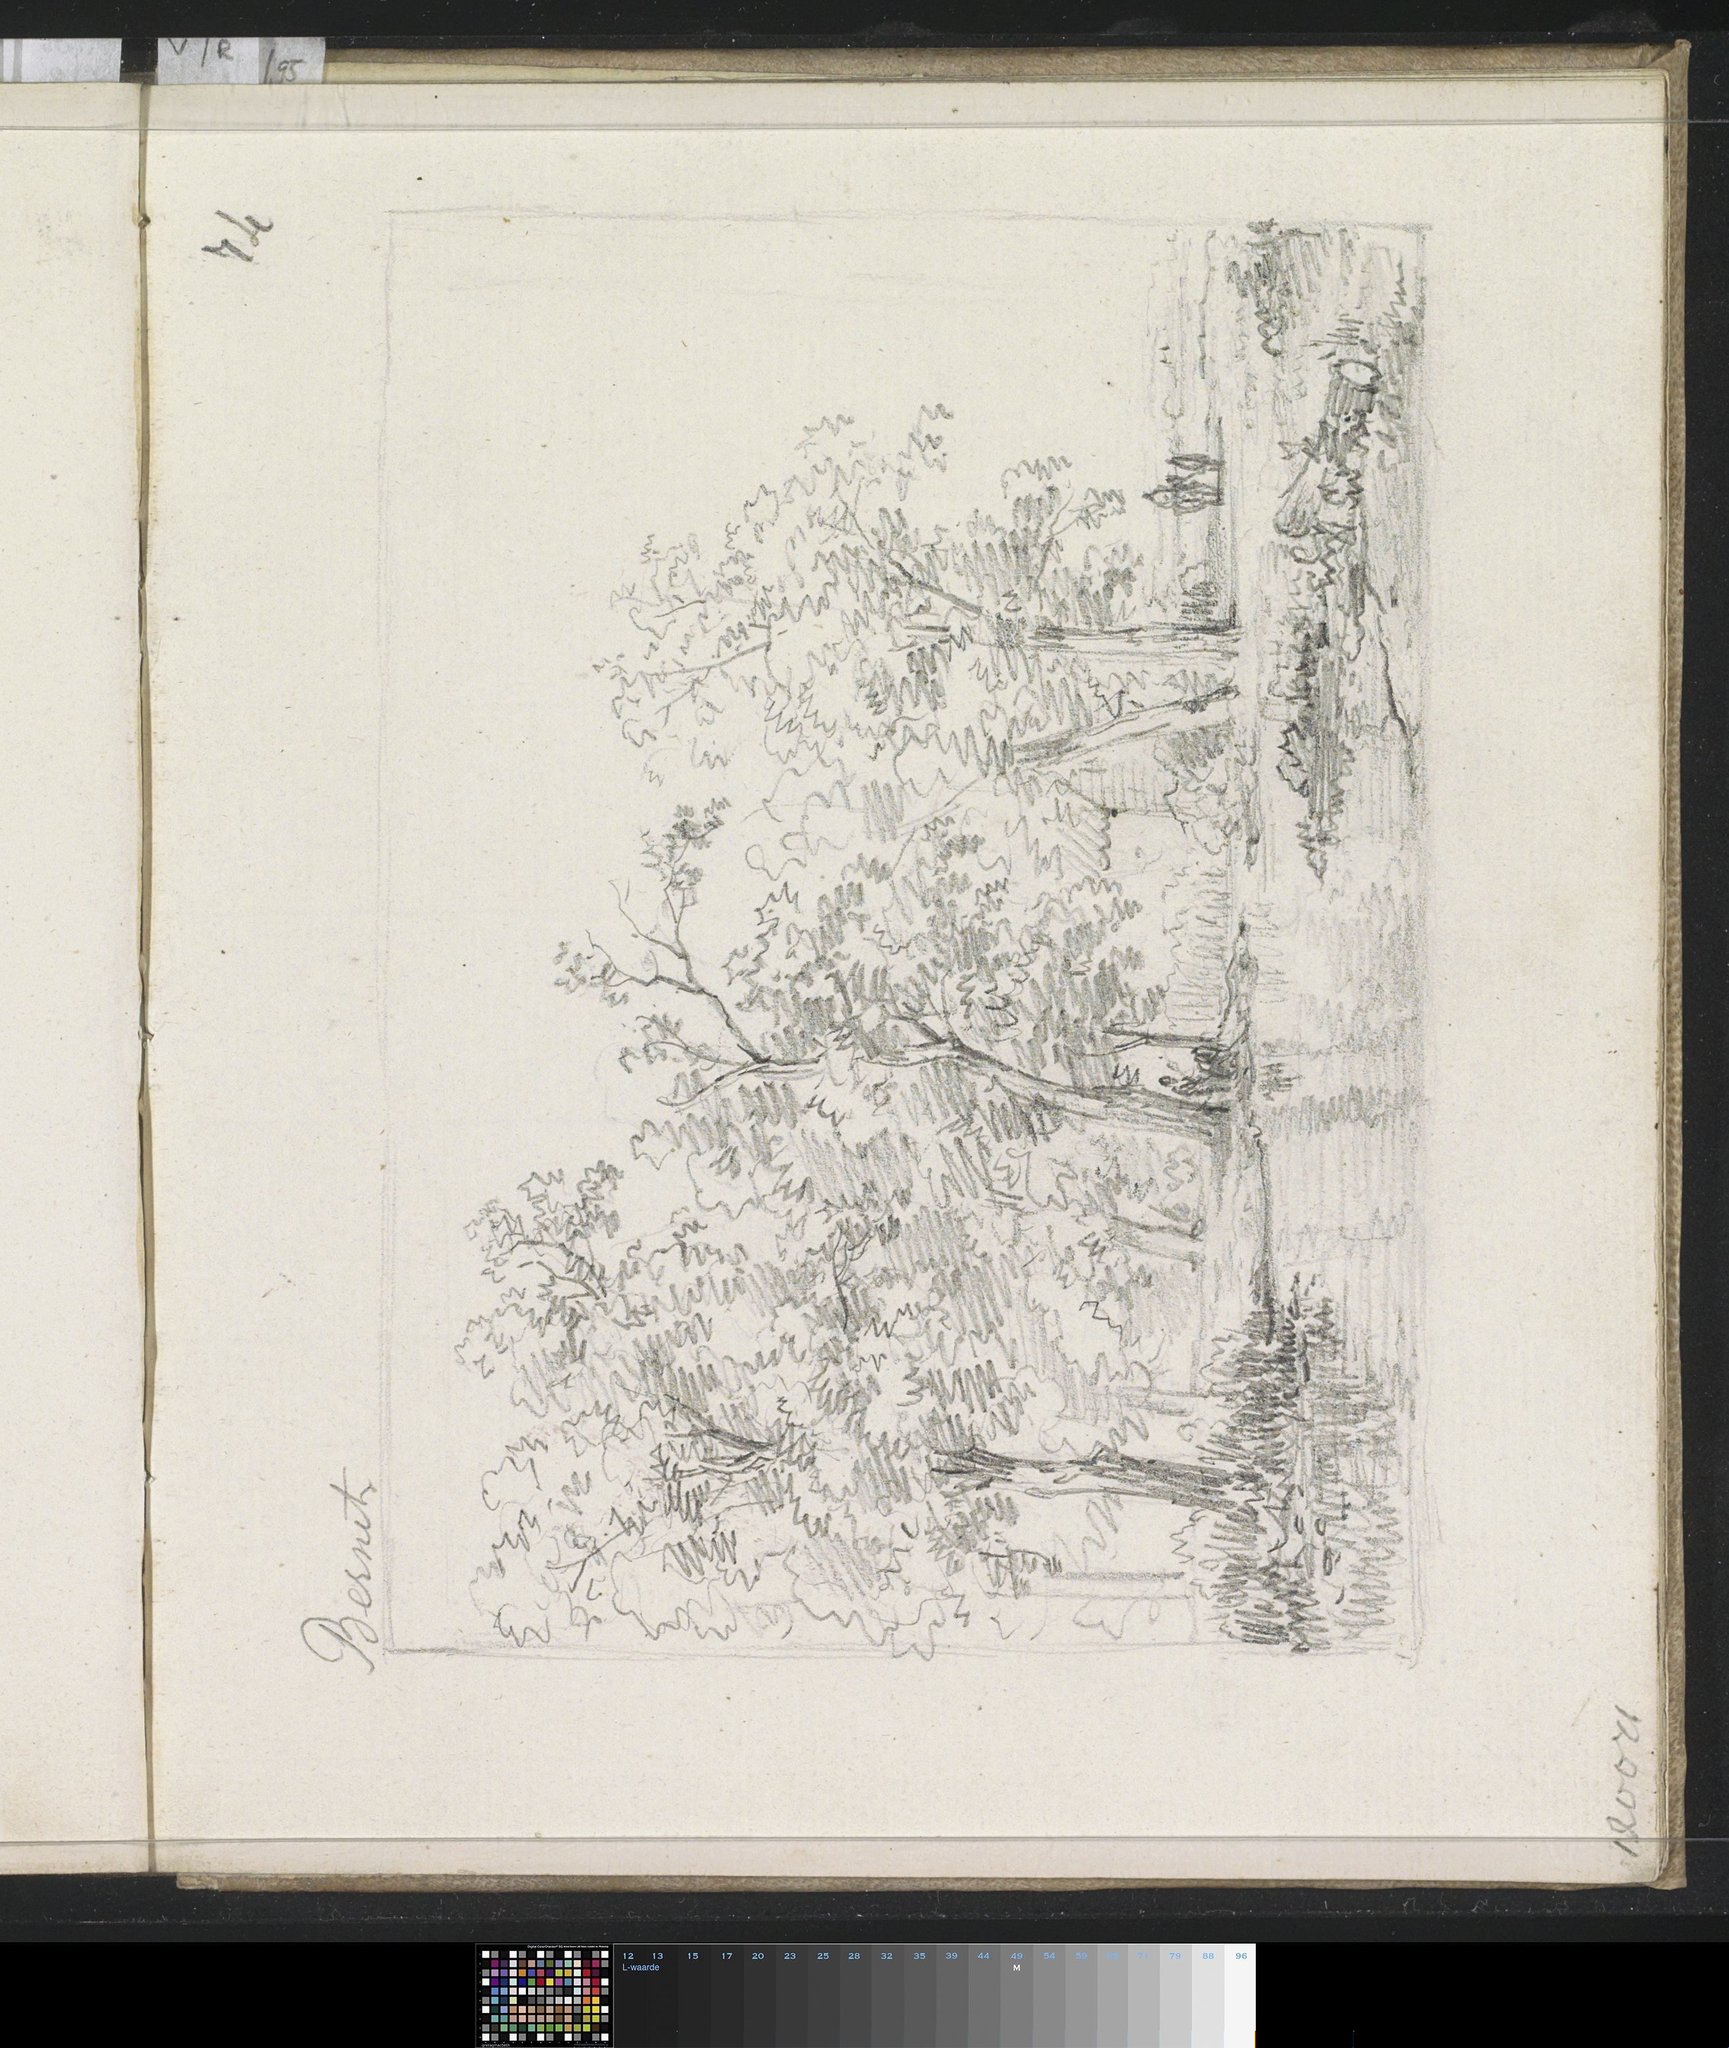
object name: sketchbook leaf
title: Figuren, bomen en een huis aan een waterkant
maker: andreas schelfhout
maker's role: draughtsman, painter, print maker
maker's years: 1787-1870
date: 1825-1828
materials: paper, pencil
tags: landscapes with waters, waterscapes, seascapes (in the temperate zone) (+ landscape with figures, staffage), farm or solitary house in landscape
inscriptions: number: ‘74/ 120071’, annotation: ‘Bernet’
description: Blad 89 recto uit een schetsboek met 95 bladen.